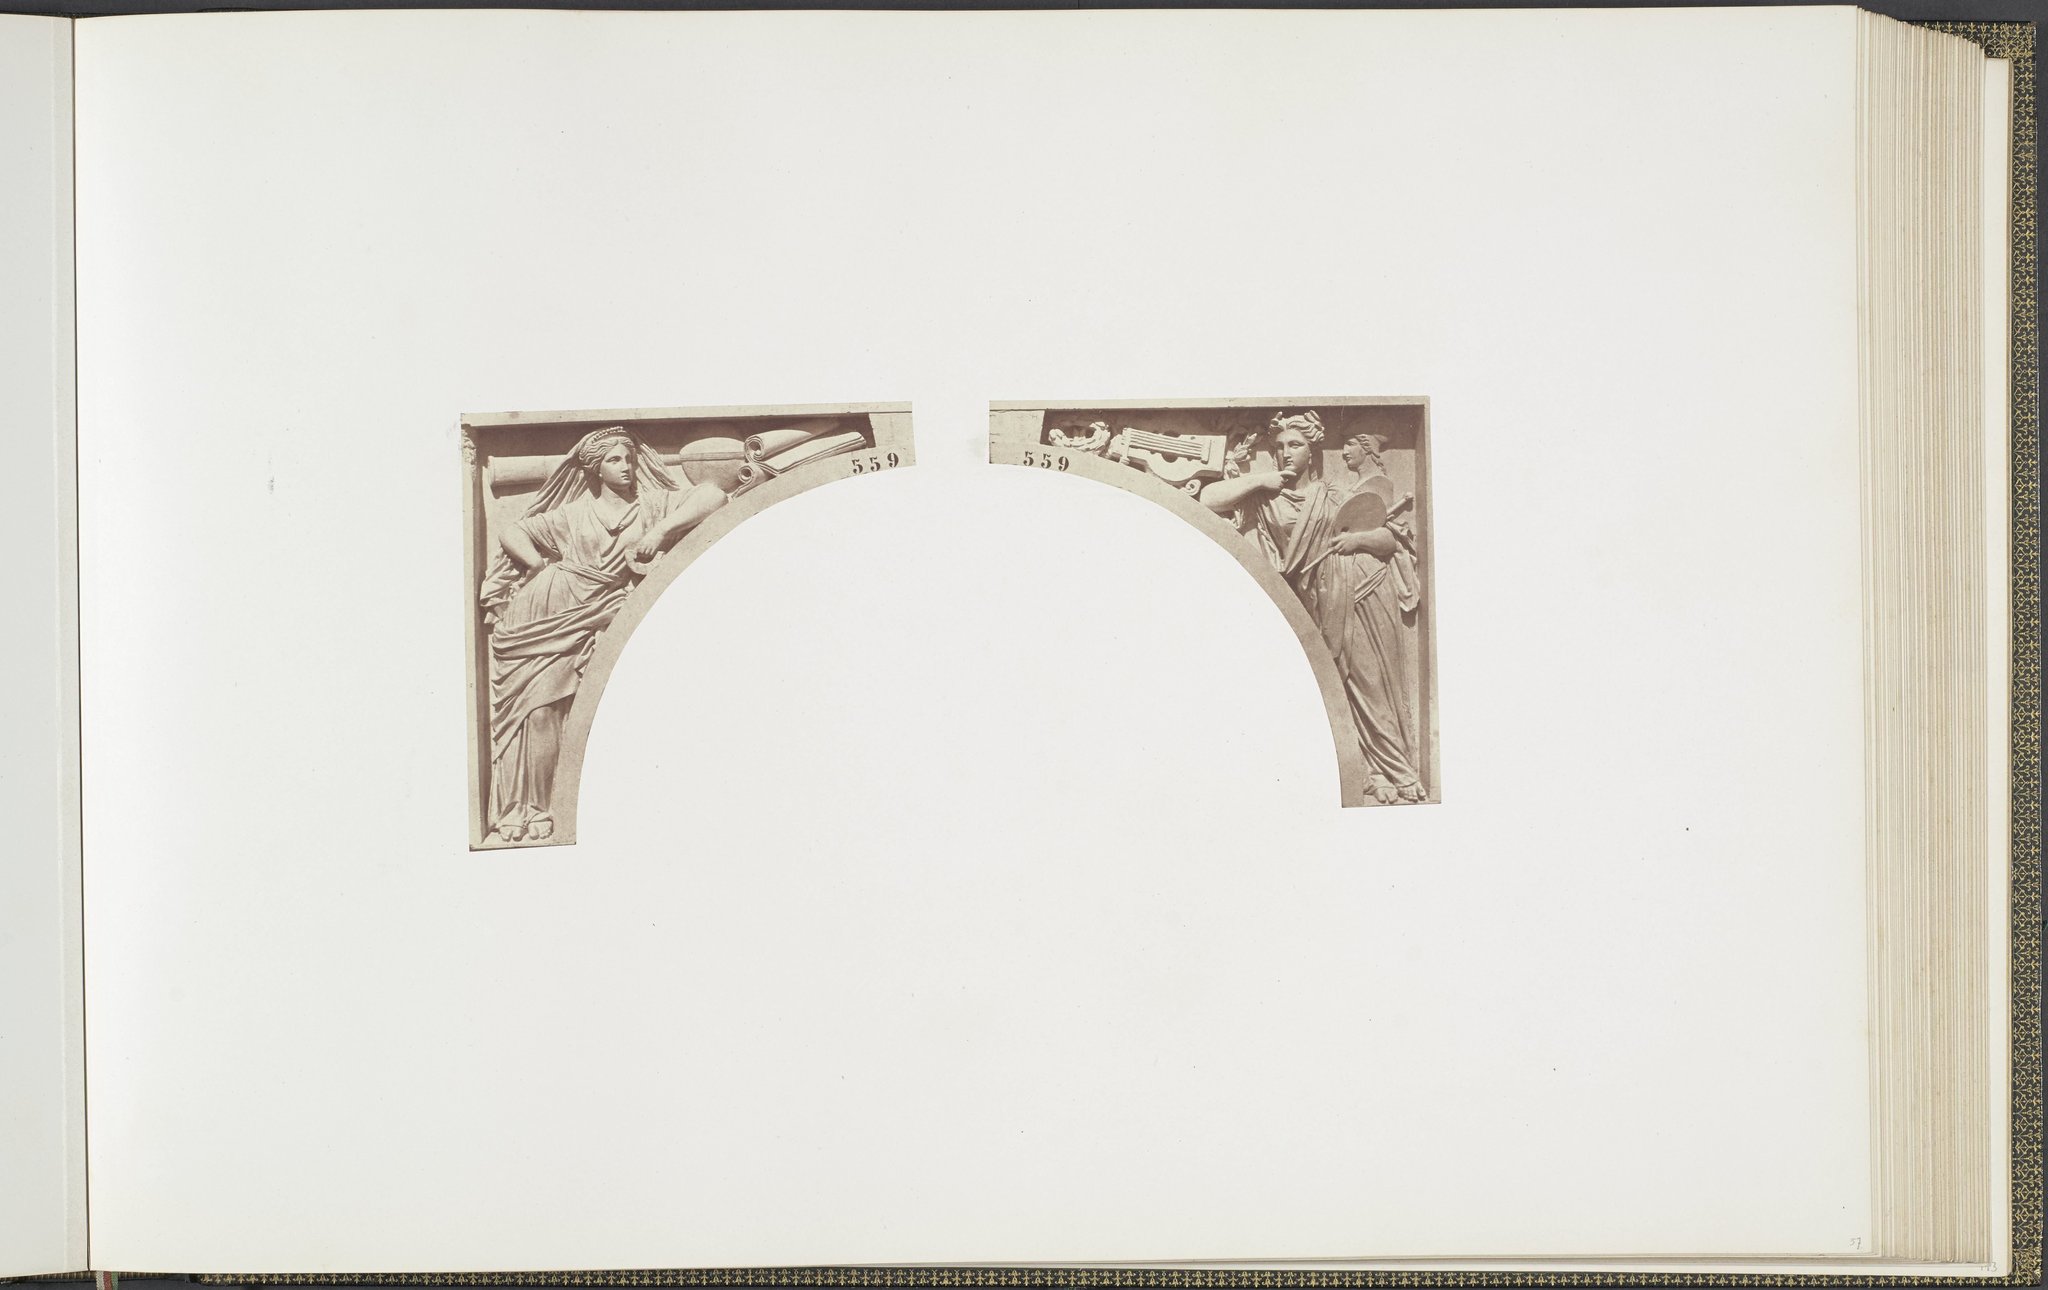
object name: album leaf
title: Gipsmodellen voor beeldhouwwerken op het Palais du Louvre: links "La Science moderne" door Emile Knecht en rechts "L'Art" door Emile Seurre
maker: édouard denis baldus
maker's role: fotograaf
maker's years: 1813-1889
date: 1855-1857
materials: paper, photographic support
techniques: salted paper print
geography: paris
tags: piece of sculpture, reproduction of a piece of sculpture, permanent exhibition, museum, paris, tuileries palace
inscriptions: number: ‘559’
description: Onderdeel van Réunion des Tuileries au Louvre 1852-1857, album 1.